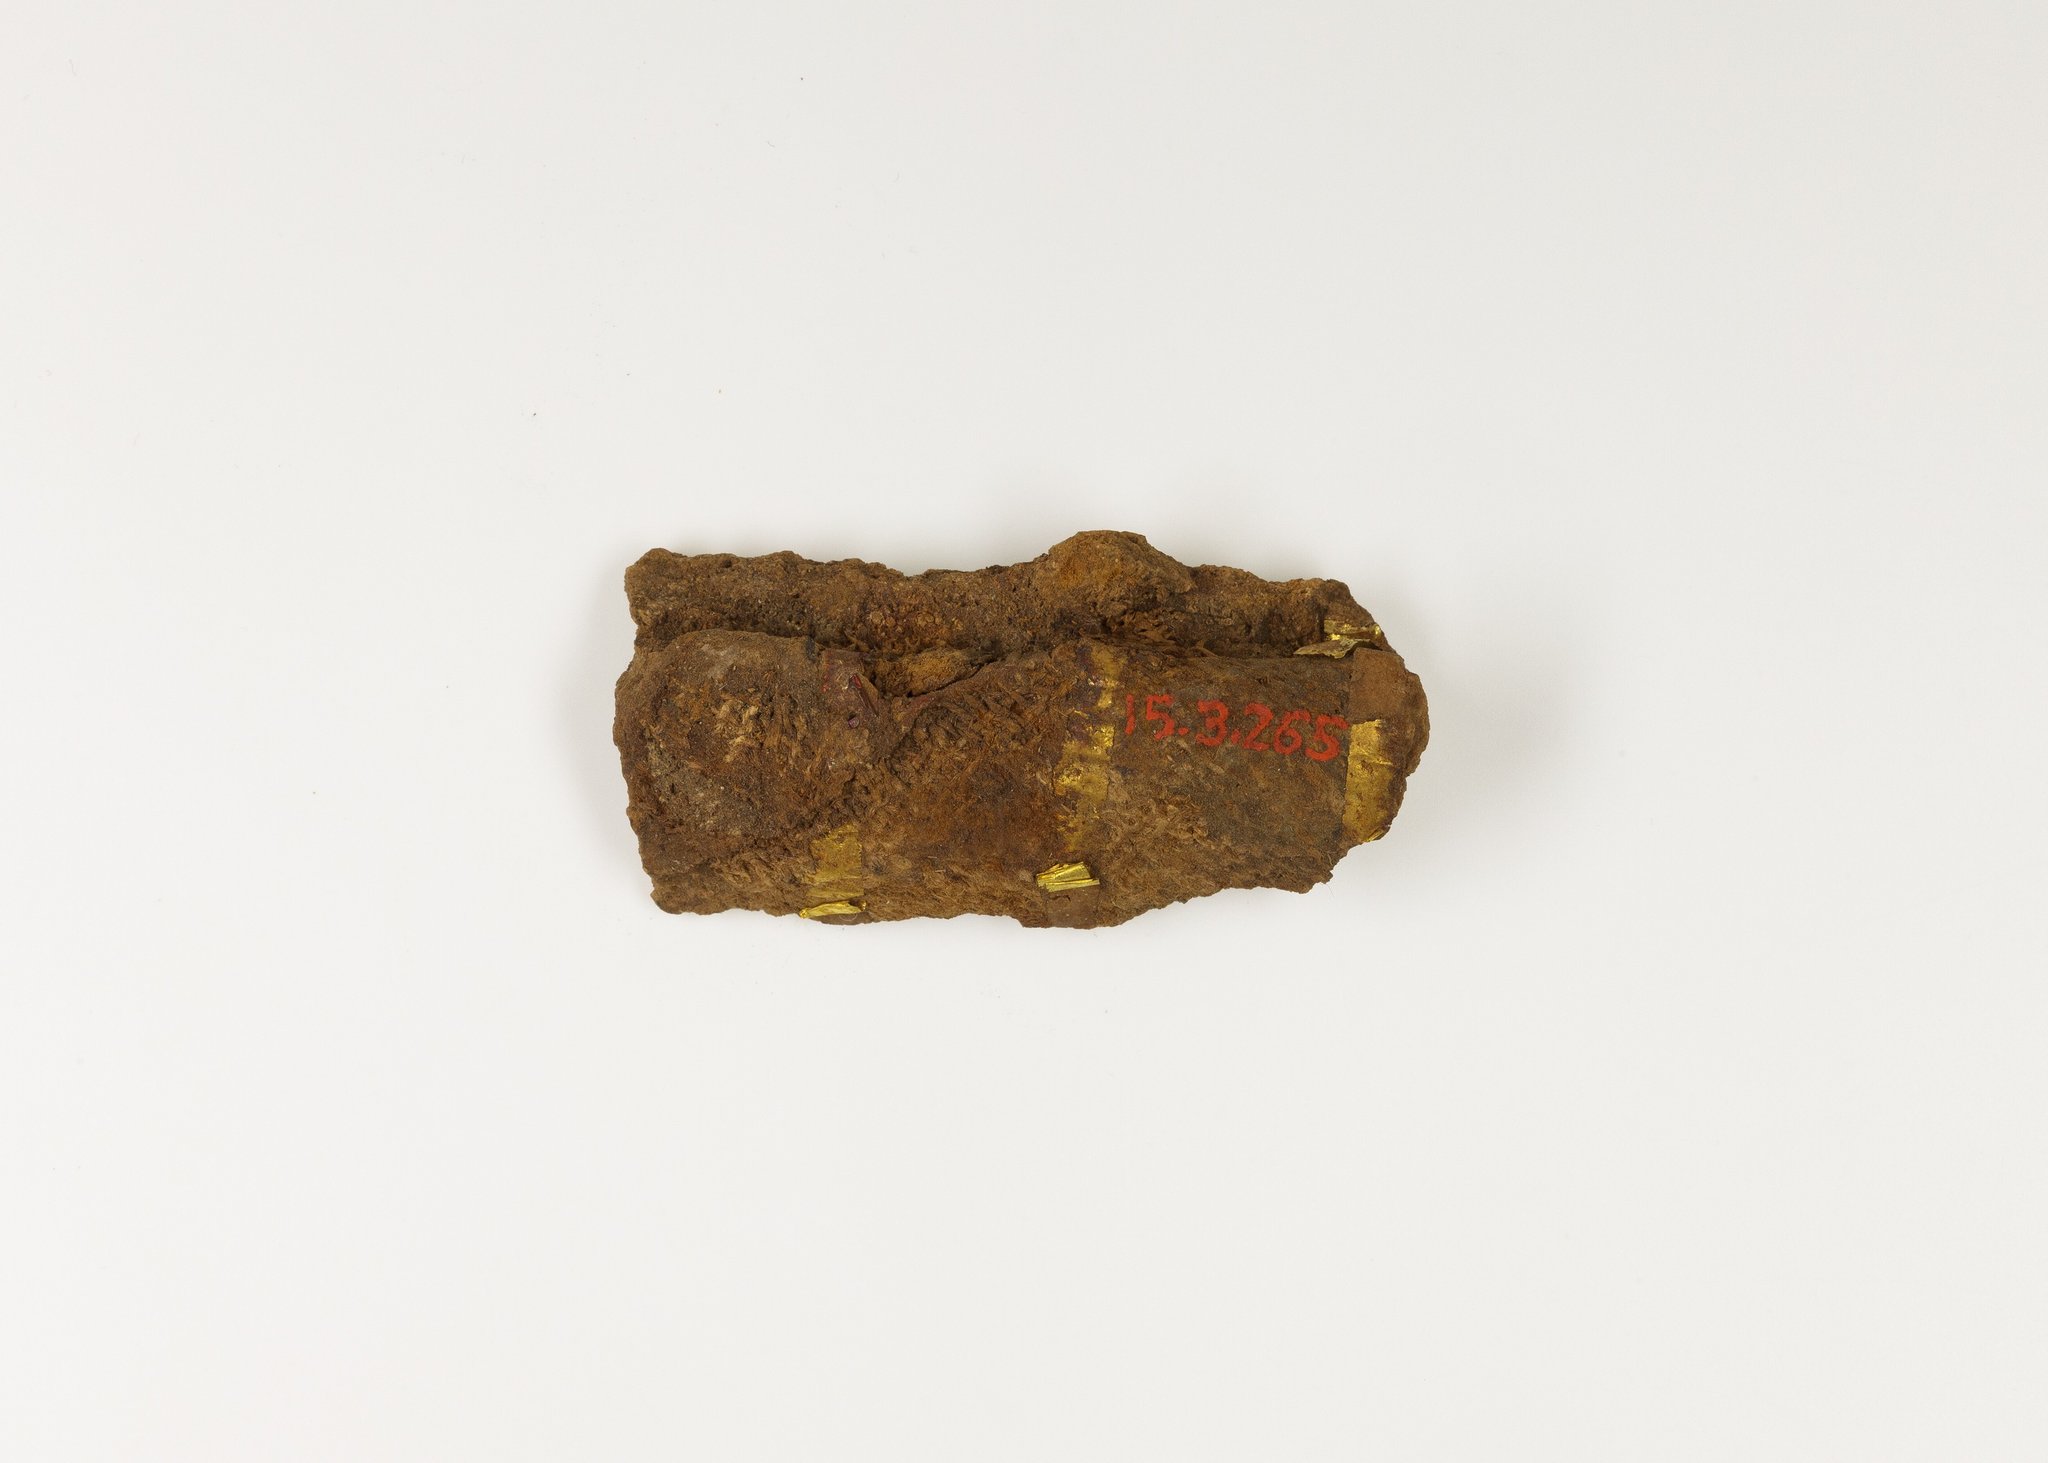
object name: gold foil on wrist, bracelet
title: Gold Foil on Wrist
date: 1981-1885 BCE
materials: gold foil